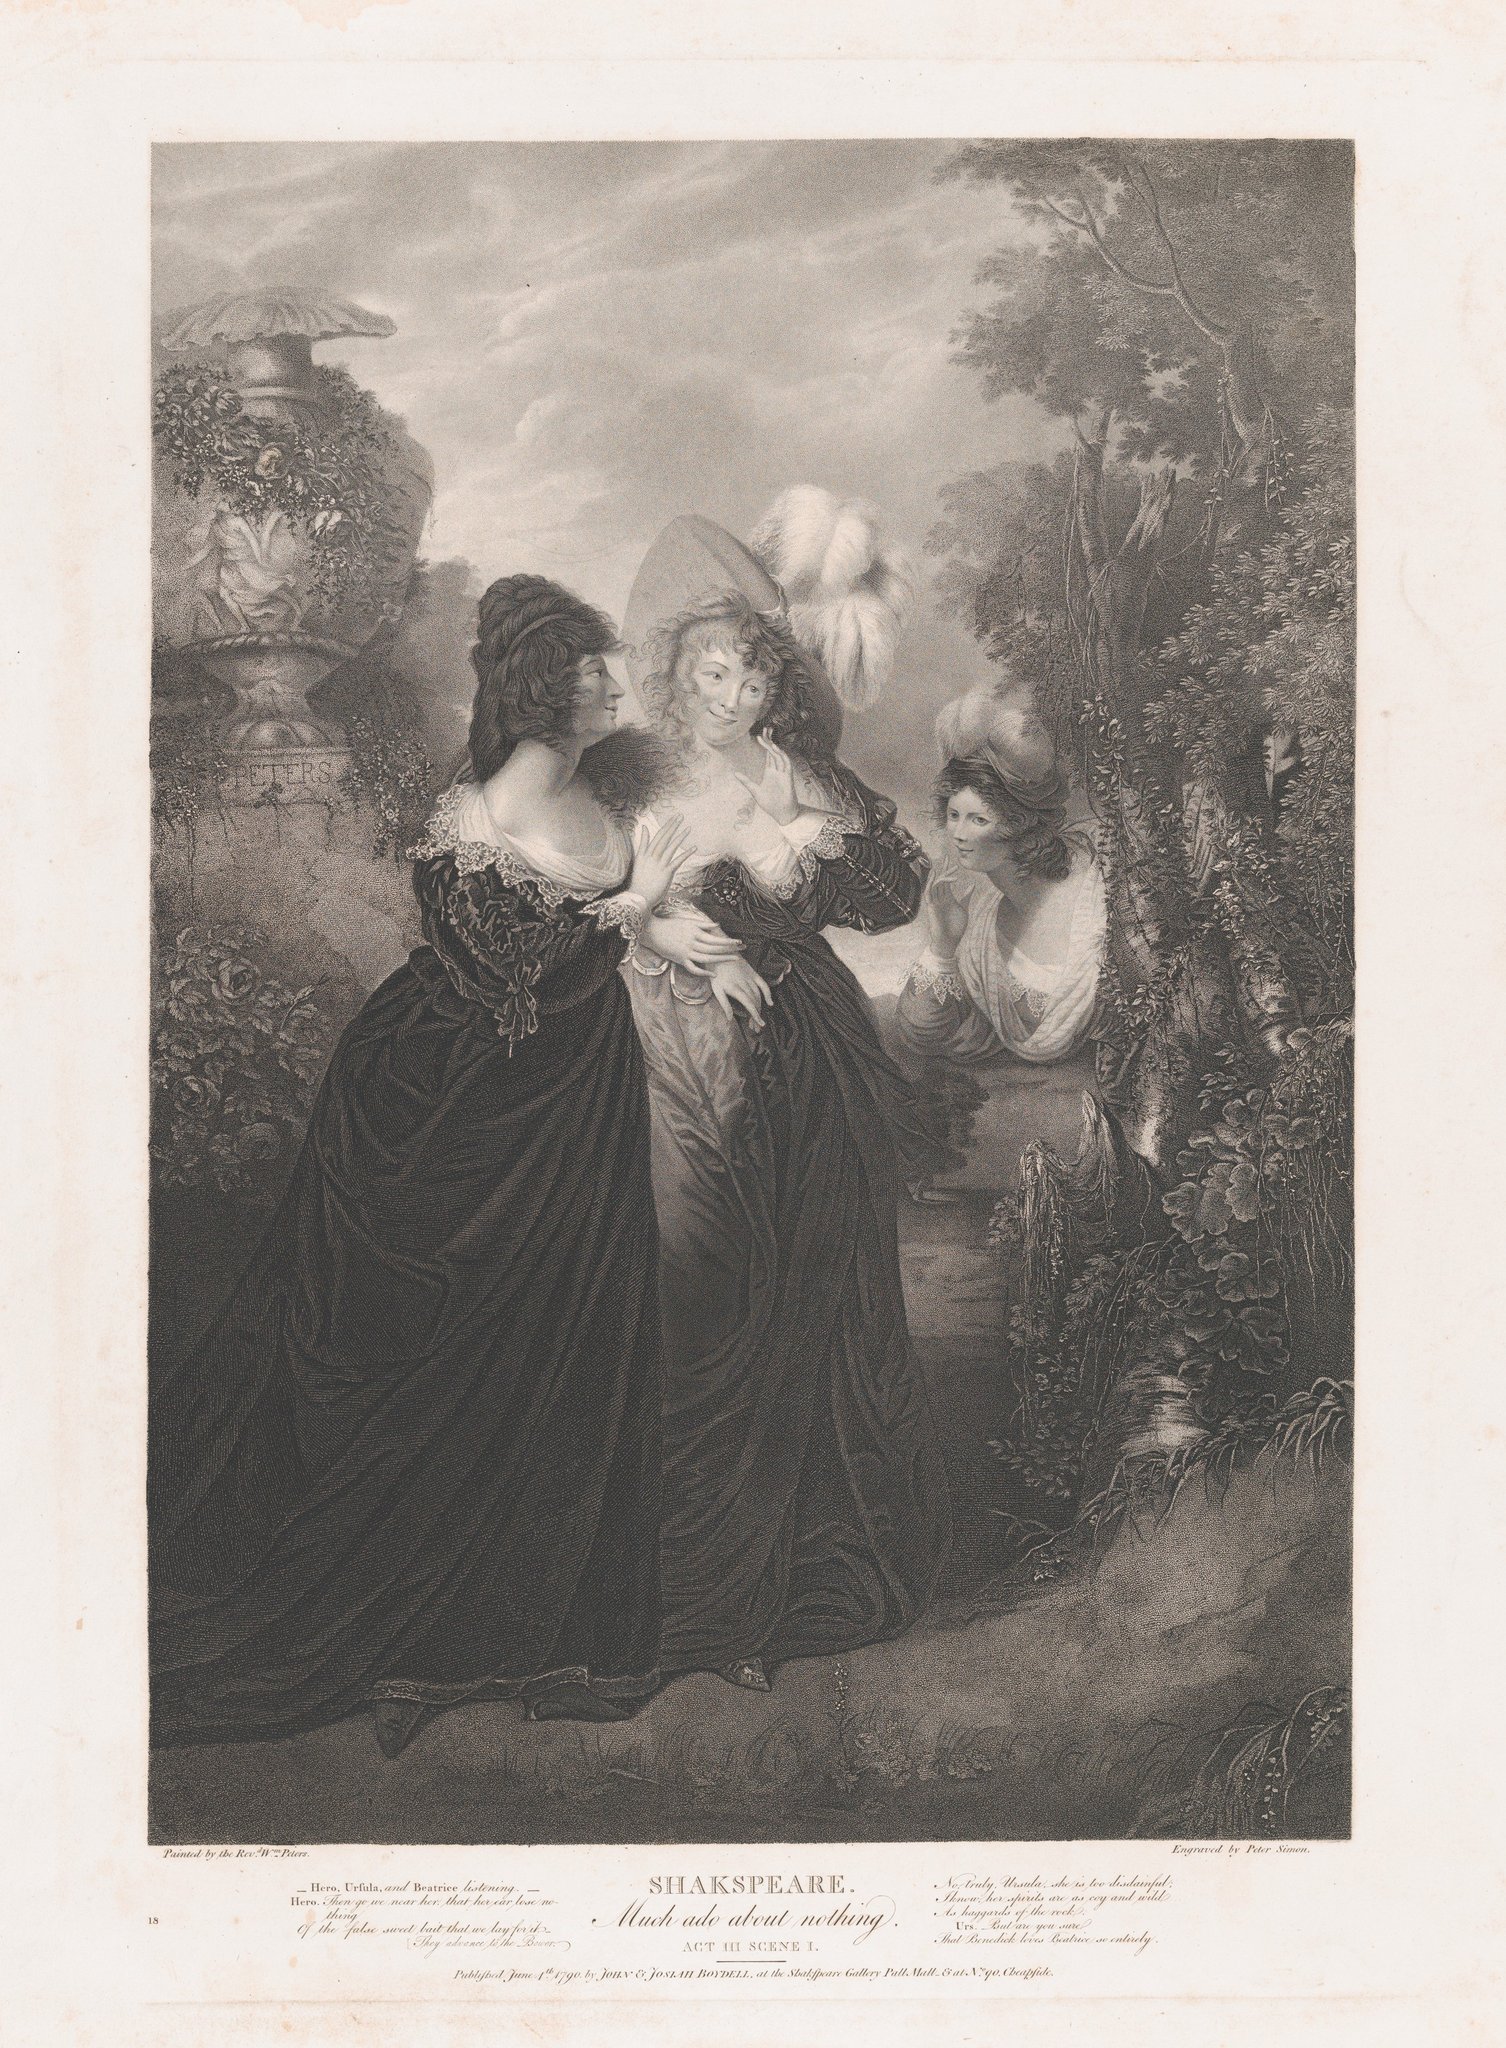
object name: print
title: Hero, Ursula and Beatrice (Shakespeare, Much Ado About Nothing, Act 3, Scene 1)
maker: peter simon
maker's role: engraver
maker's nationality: british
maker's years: 1764-1813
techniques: engraving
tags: shakespeare,women